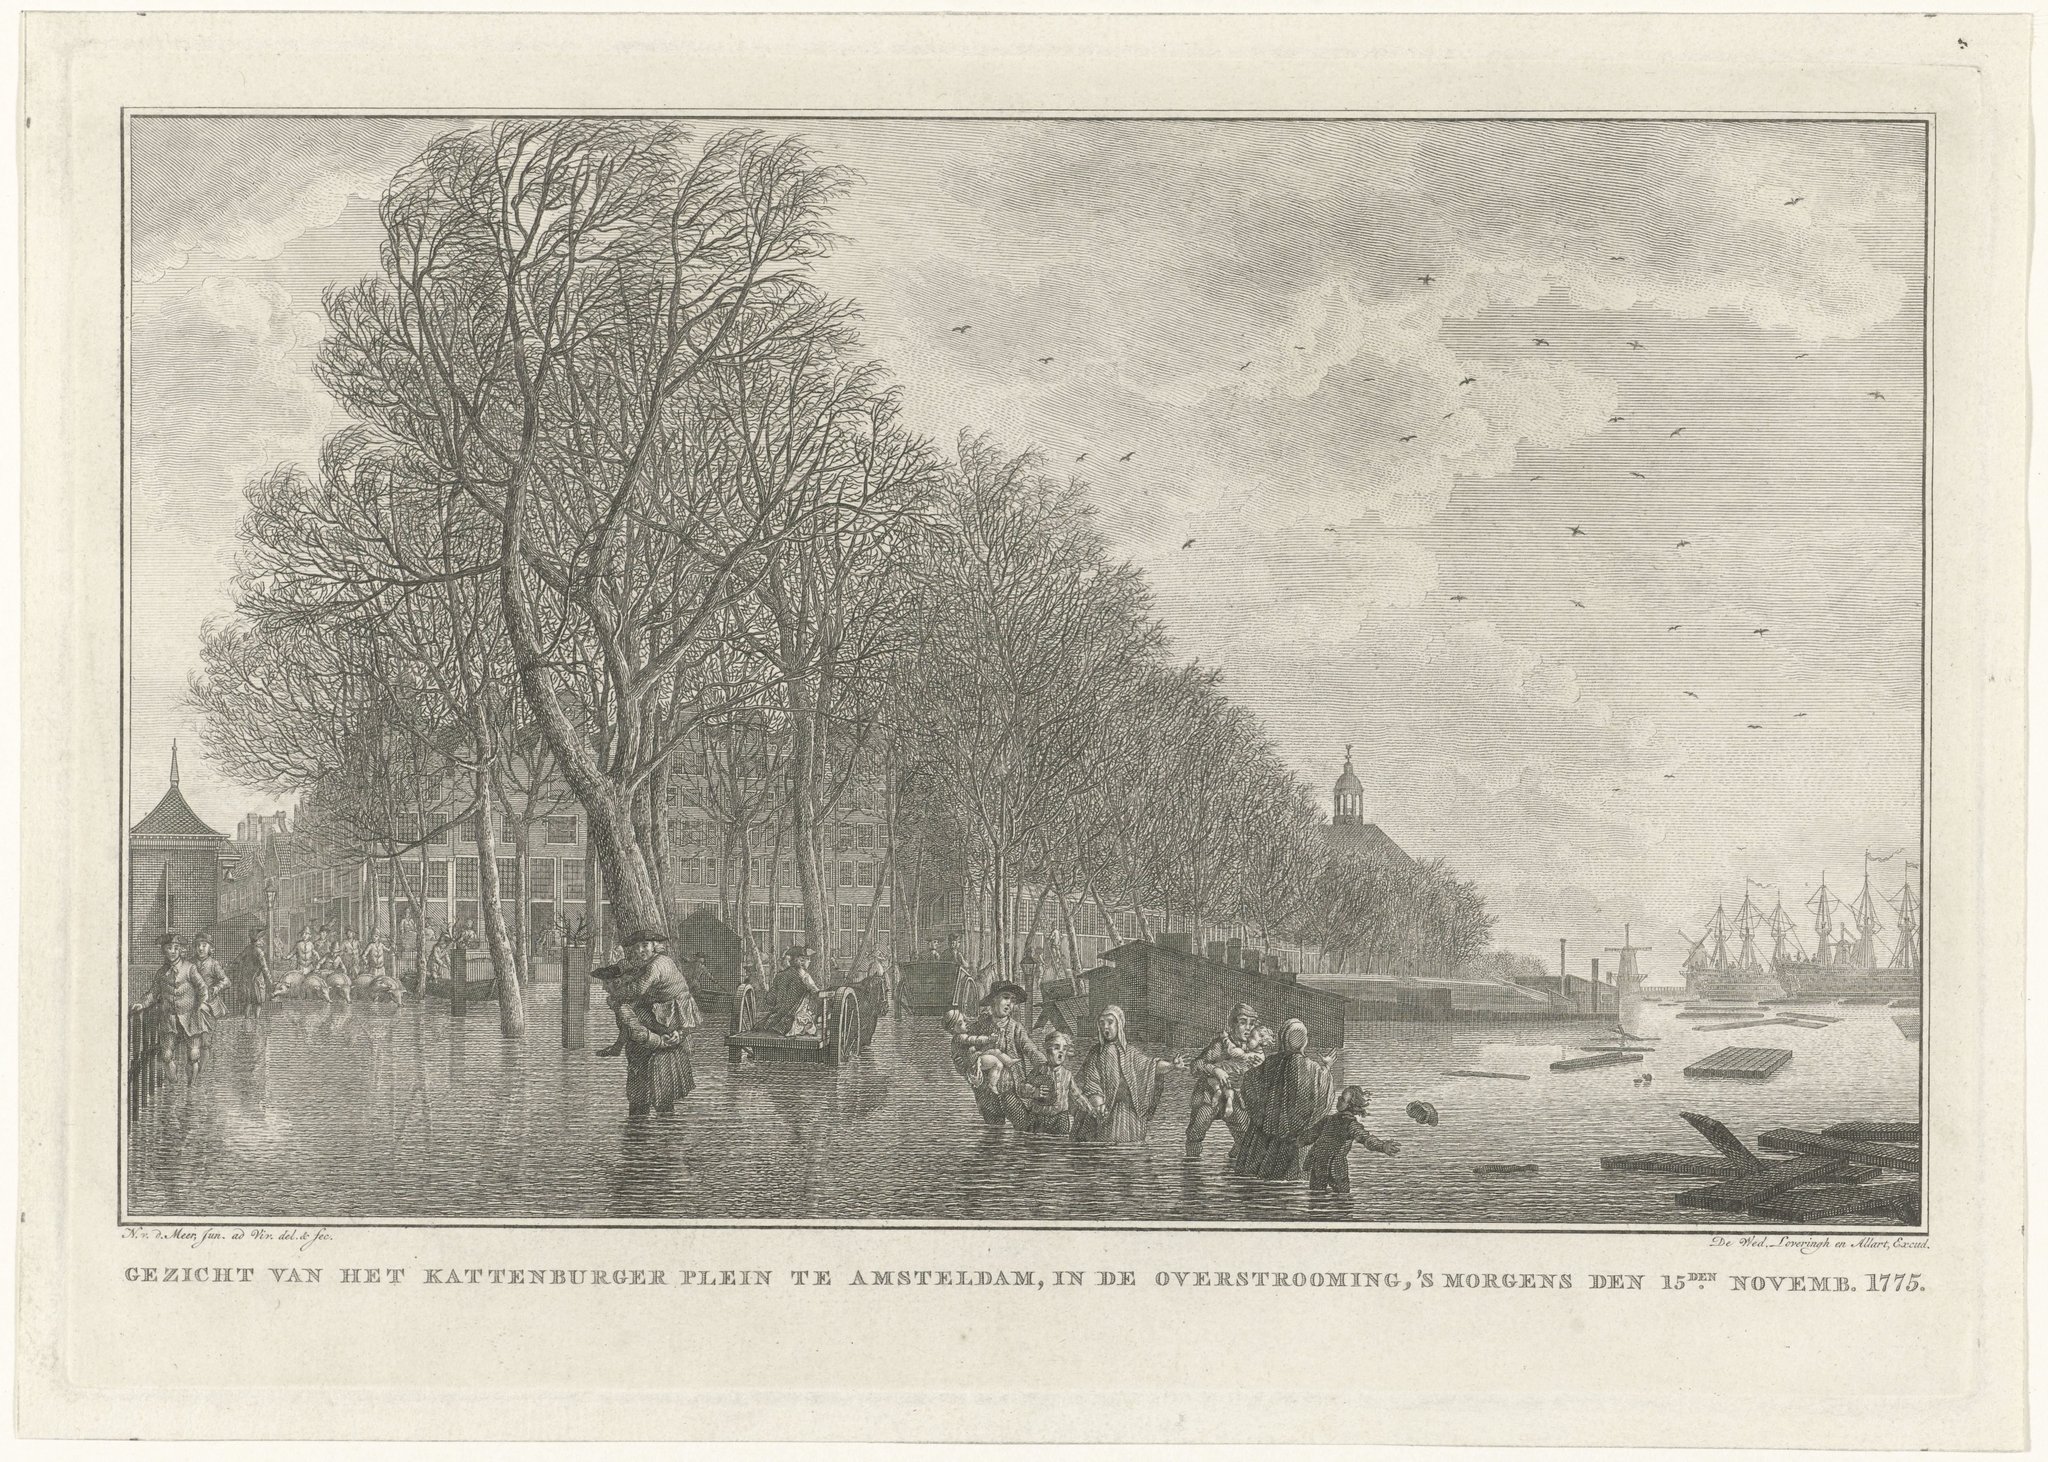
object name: print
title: Watersnood op het Kattenburgerplein te Amsterdam, 1775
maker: noach van der meer (ii)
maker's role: draughtsman, print maker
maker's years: 1741-1822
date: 1775-1776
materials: paper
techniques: engraving, etching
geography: amsterdam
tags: rescue work during a flood, dike-break, the flood of 14-18 november 1775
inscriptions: collector's mark: Lugt 2228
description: Huidige staat van prent (evenals eerste bekende staat) ook gebruikt in: Hering, Johan Hendrik. Bespiegeling over Neêrlandsch waternood, tusschen den 14den. en 15den. nov: MDCCLXXV. 2 delen. Amsterdam: weduwe Jacobus Loveringh & Johannes Allart, 1776, dl. 1. Voor eerste bekende staat zie RP-P-OB-23.507. Voor derde bekende staat zie RP-P-OB-23.505.